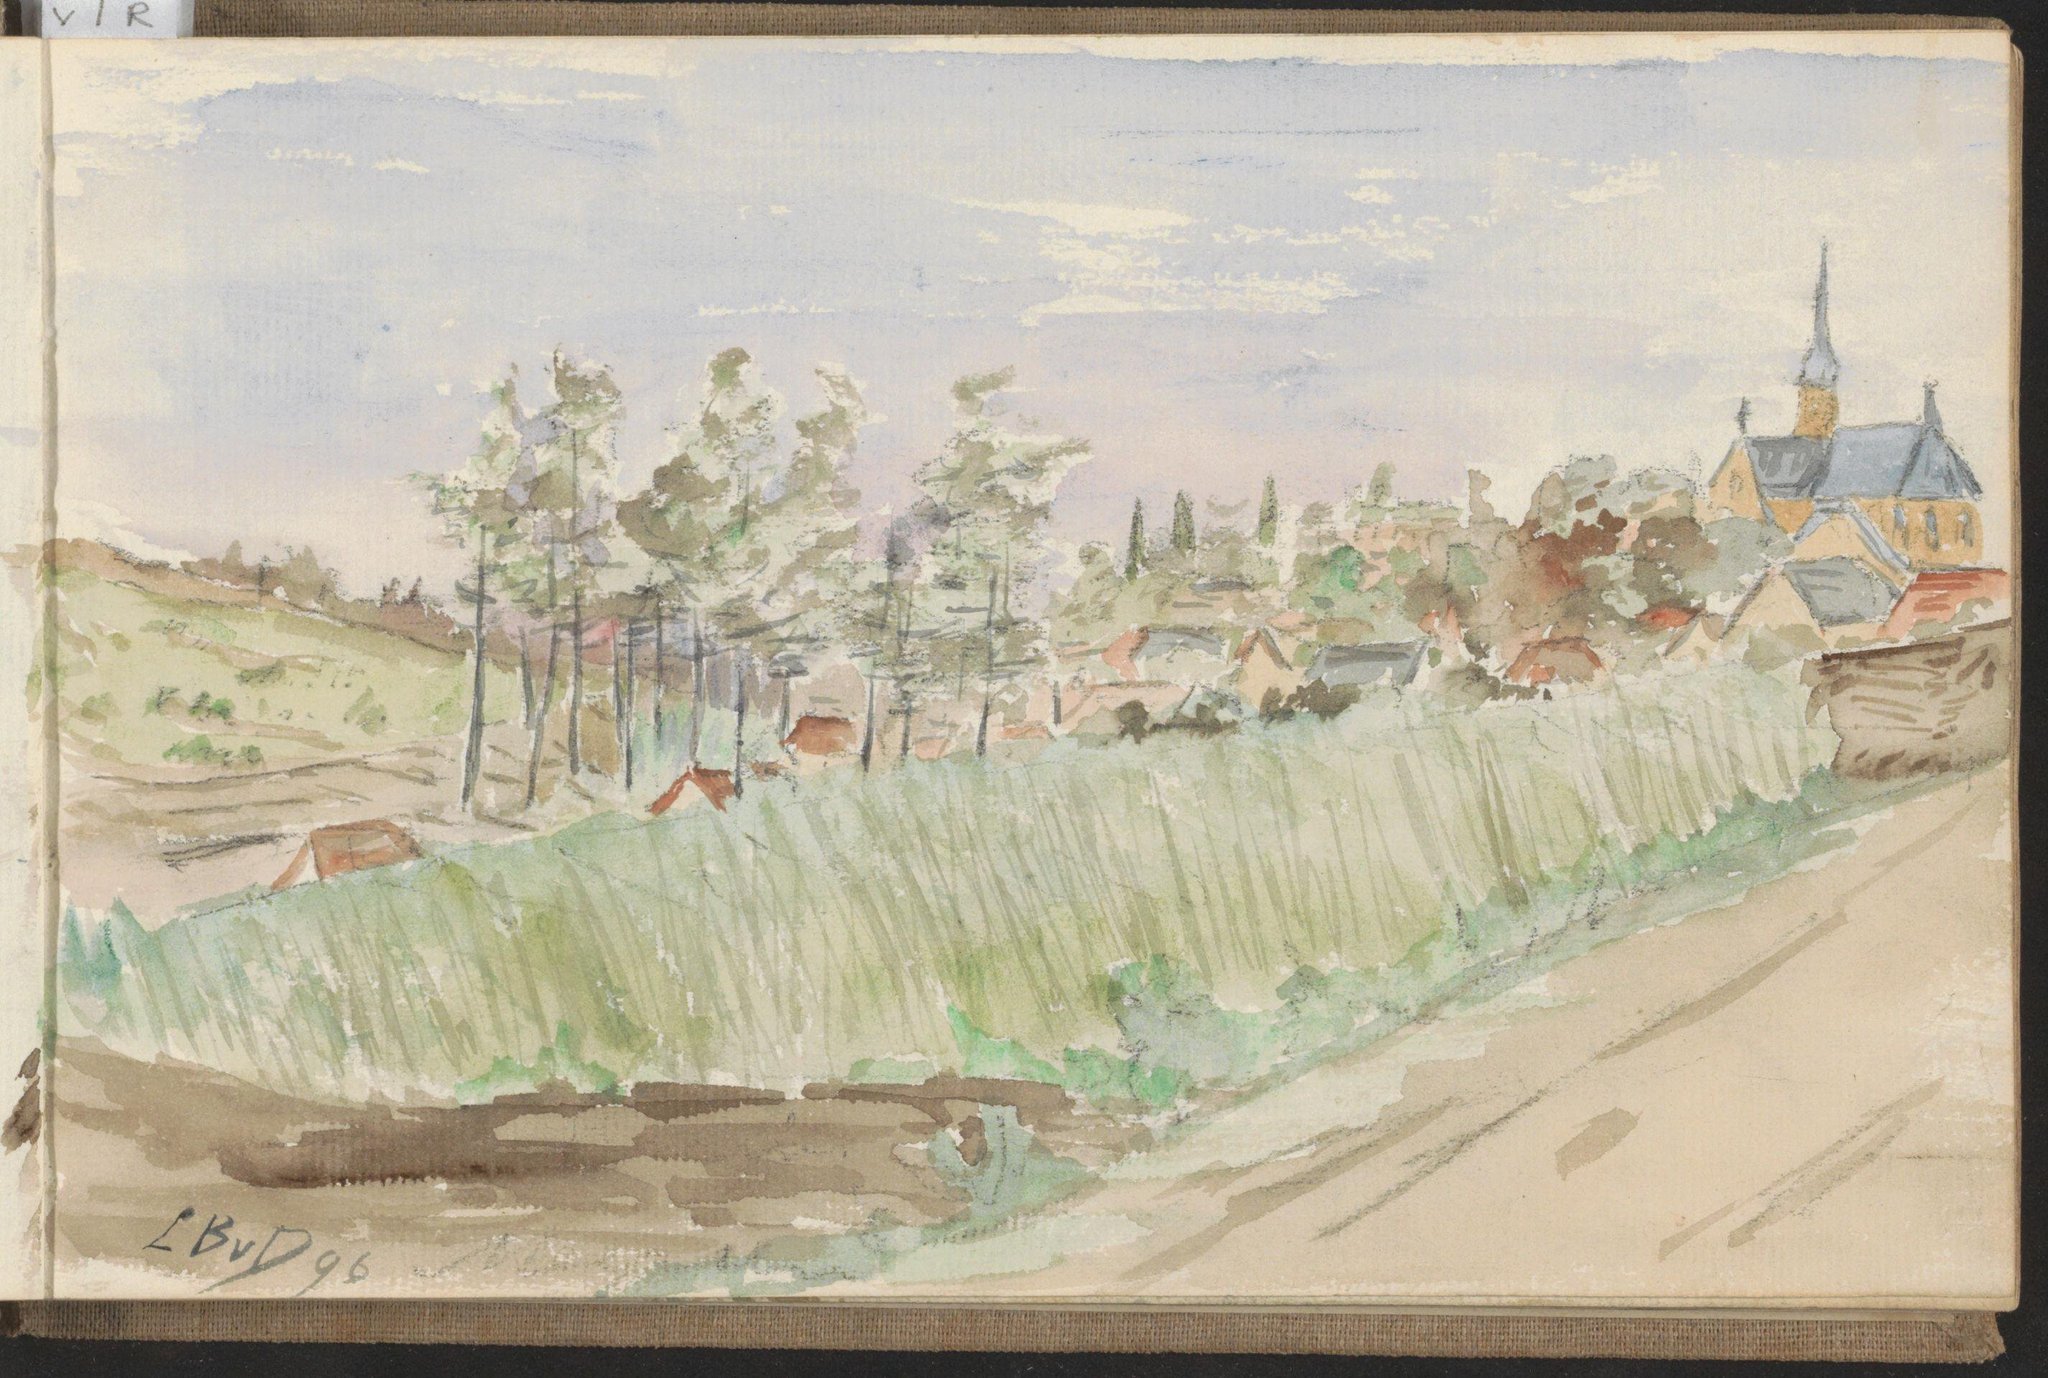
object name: sketchbook leaf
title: Gezicht op Heerlen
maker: jonkheer johannes ludovicus paulus bosch van drakestein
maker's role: draughtsman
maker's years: 1865-1929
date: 1896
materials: paper, pencil, watercolor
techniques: brush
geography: heerlen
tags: city-view, and landscape with man-made constructions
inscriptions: signature and date: ‘LBvD96’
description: Blad 9 recto uit een schetsboek met 58 bladen.